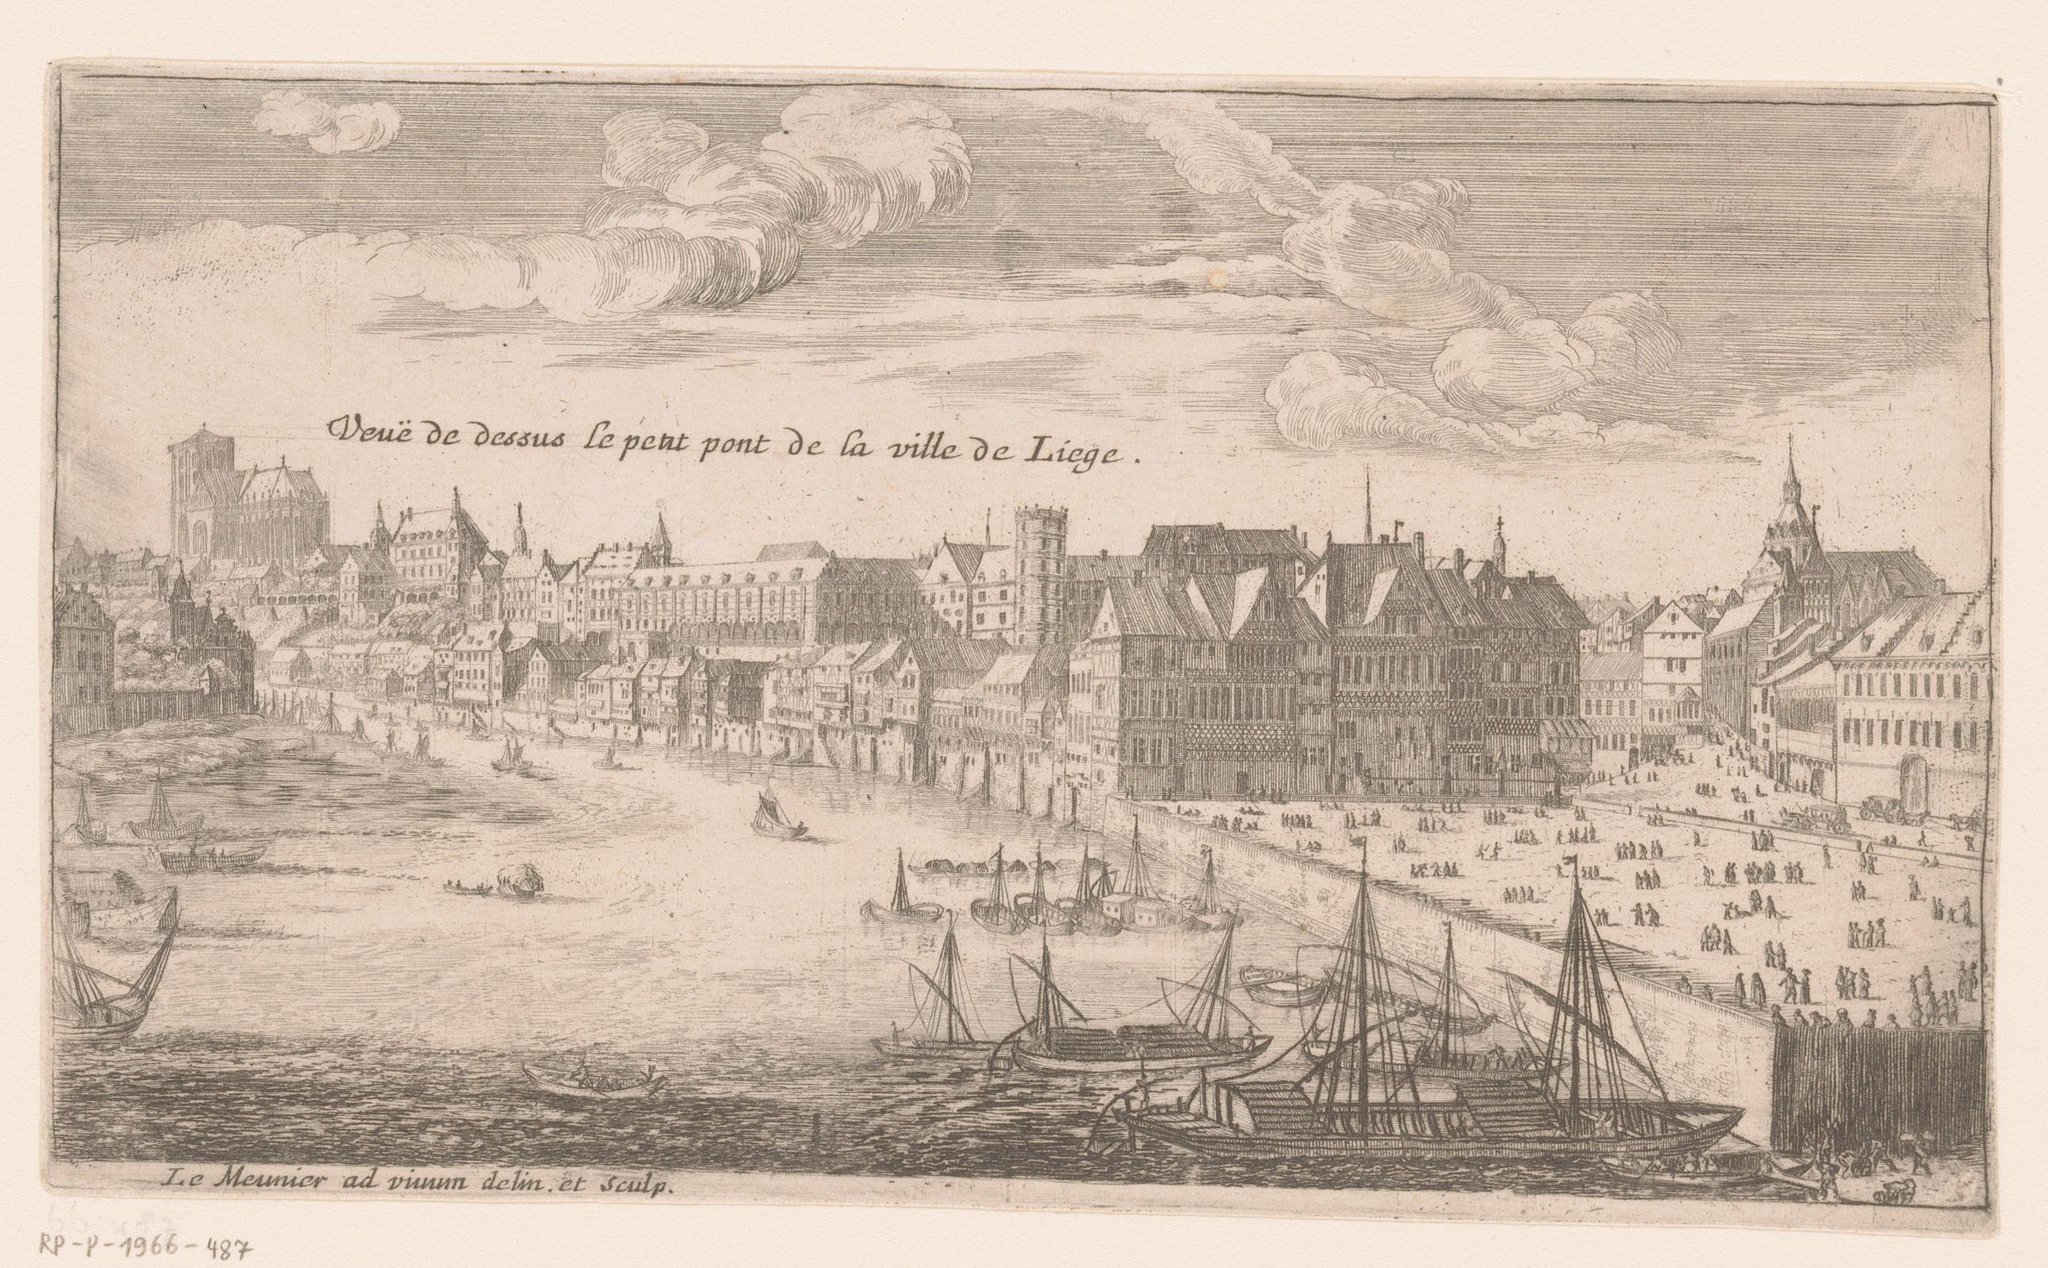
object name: print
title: Gezicht op Luik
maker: louis le meunier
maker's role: print maker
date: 1660-1673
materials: paper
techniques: engraving, etching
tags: city-view in general; 'veduta', landscapes with waters, waterscapes, seascapes (in the temperate zone), liège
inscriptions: collector's mark: Lugt 2228, watermark